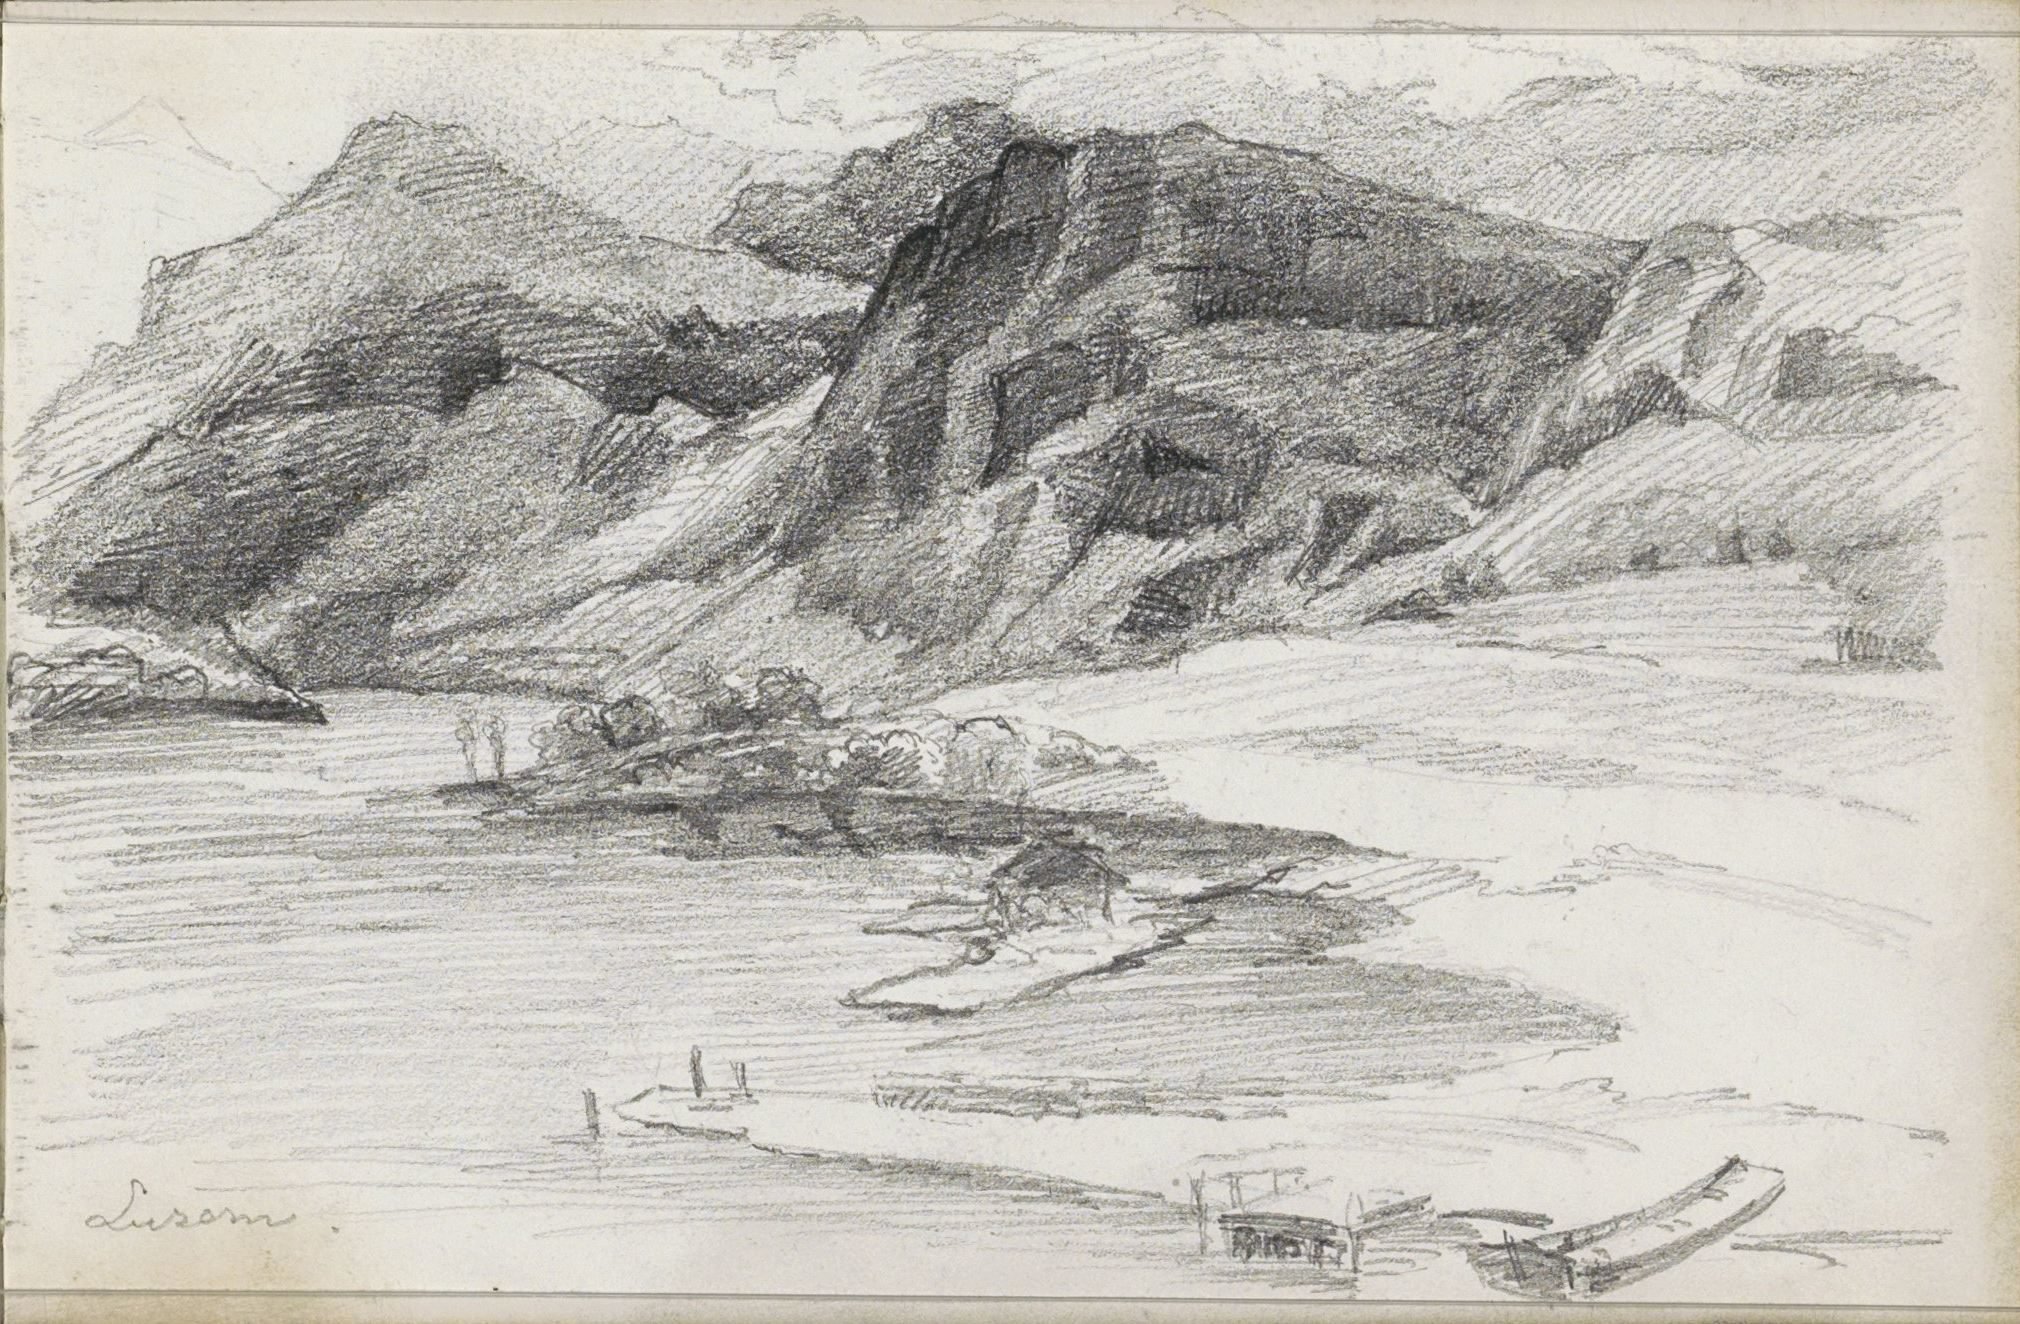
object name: sketchbook leaf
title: Kust bij Luzern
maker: isaac gosschalk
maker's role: draughtsman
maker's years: 1838-1907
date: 1860-1861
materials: paper, pencil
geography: lucerne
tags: mountains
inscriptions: annotation: ‘Luzern’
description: Blad 20 recto uit een schetsboek met 29 bladen.